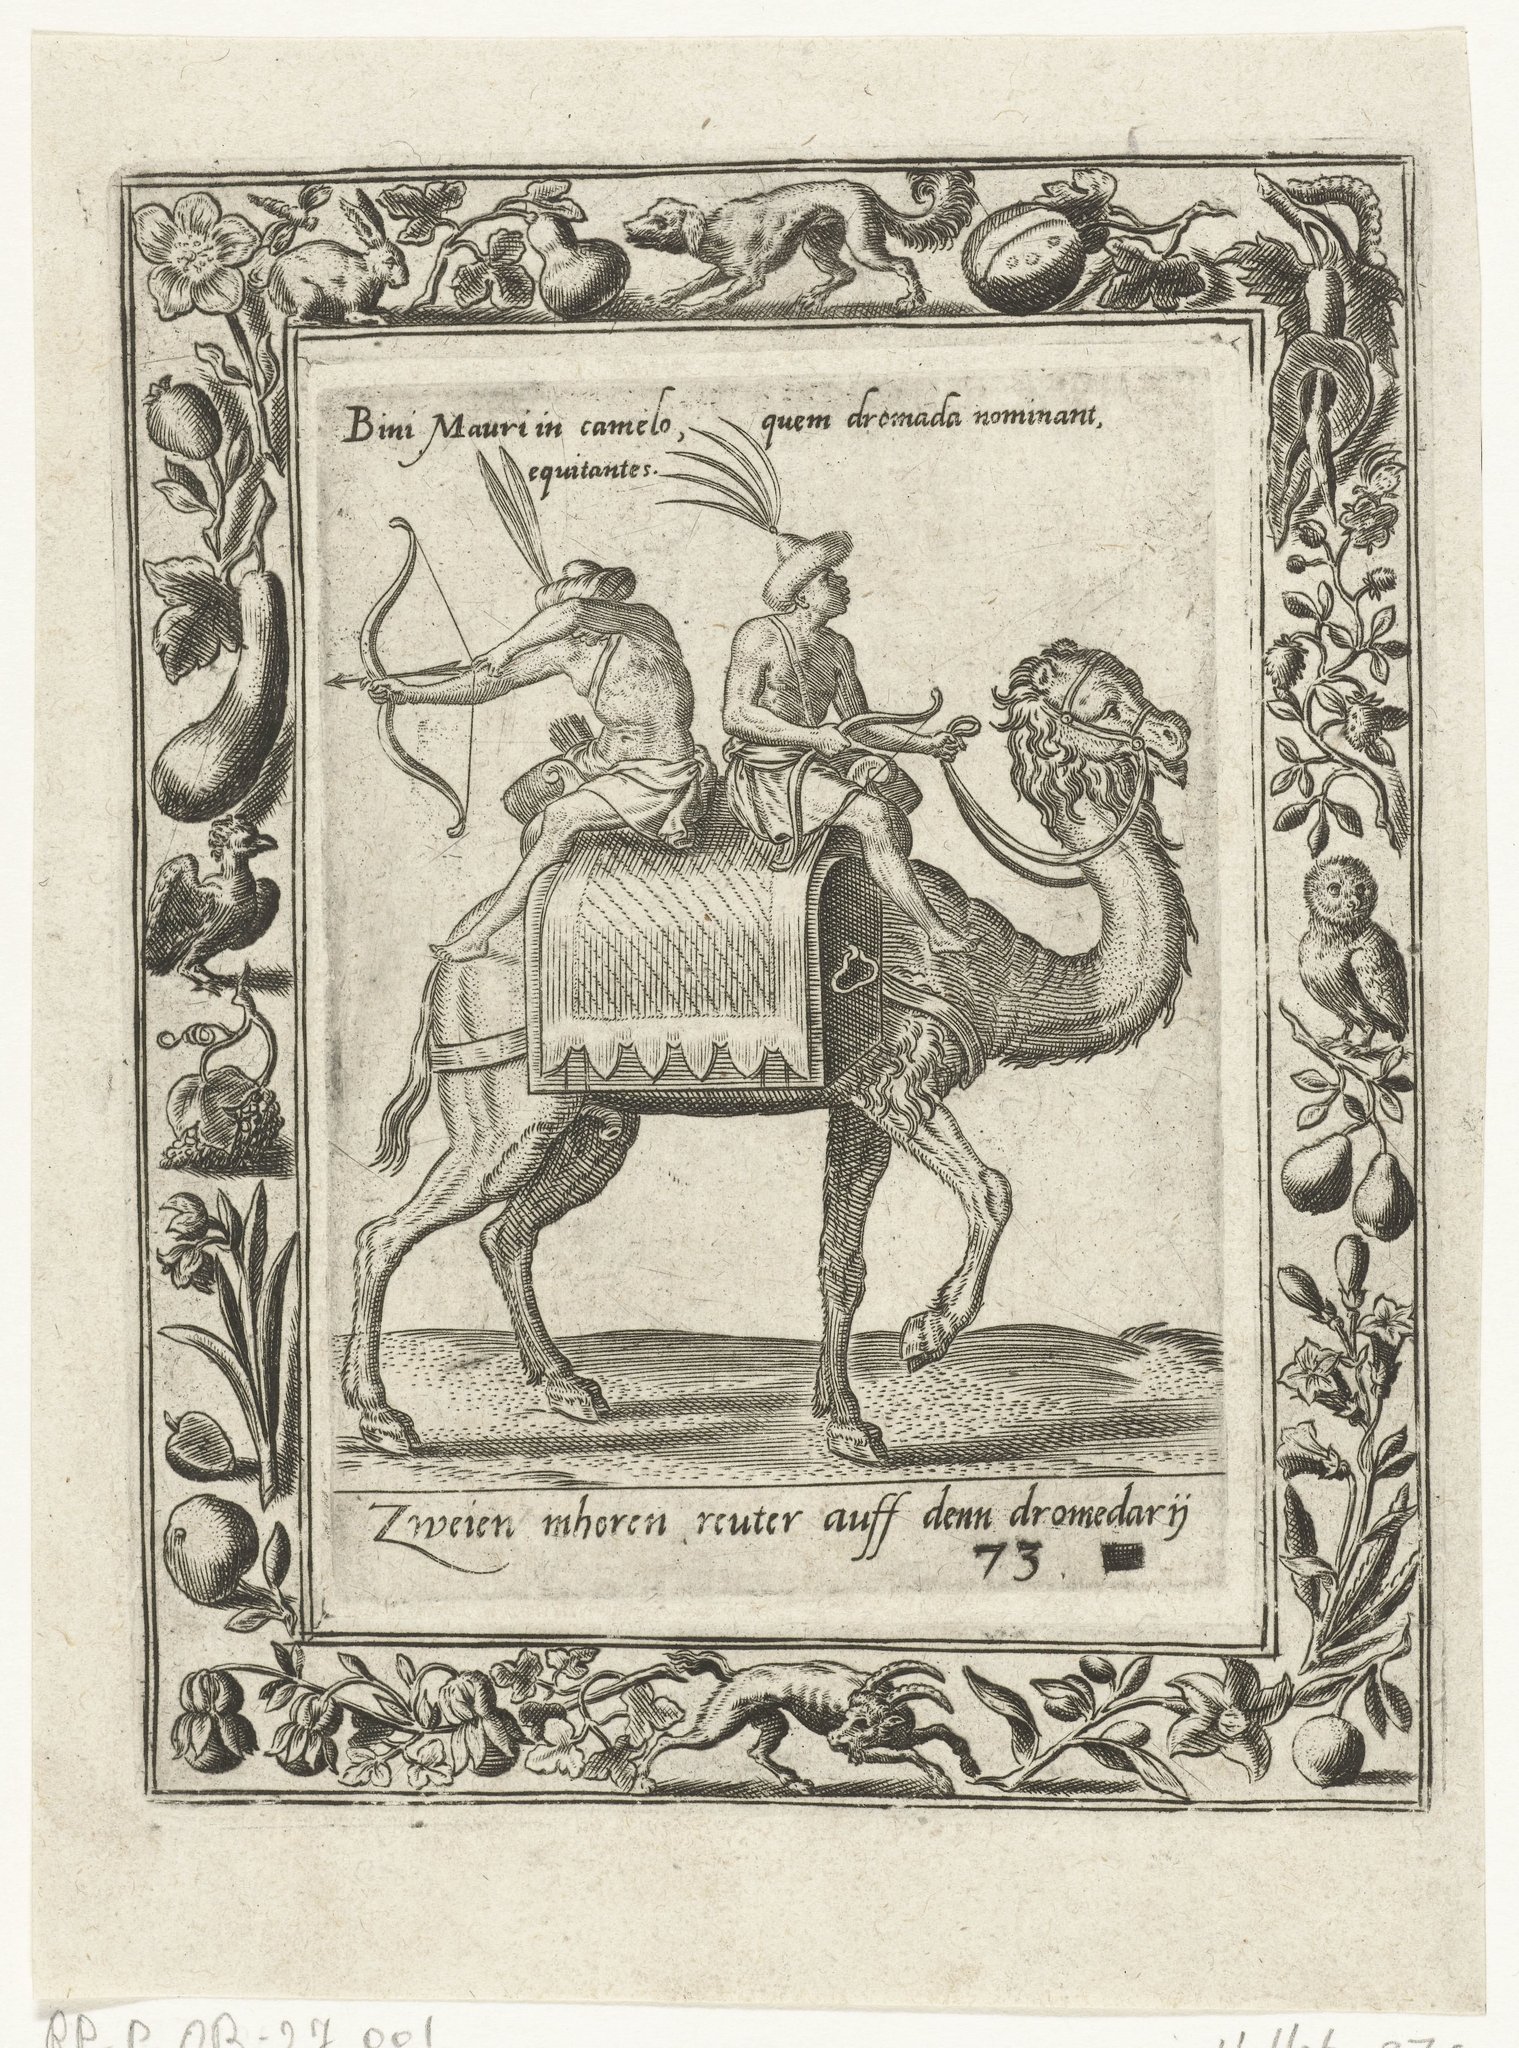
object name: costume print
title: Twee Moren op een dromedaris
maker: abraham de bruyn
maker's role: print maker, publisher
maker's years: 1540-1587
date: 1577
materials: paper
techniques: engraving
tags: hoofed animals: dromedary, folk costume, regional costume, asiatic races and peoples (with name), warfare; military affairs (+ mounted troops on other animals than horses)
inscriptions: collector's mark: Lugt 2228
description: Cartouche met afbeelding van dromedaris en twee ruiters naar rechts. De dromedaris is in stap. Zijn twee berijders zijn van Moorse afkomst. Een heeft een boog in zijn handen en schiet een pijl af. De prent heeft een Duits onderschrift en Latijns opschrift. Prent oorspronkelijk uit 'Equitum descripcio...', 1577.